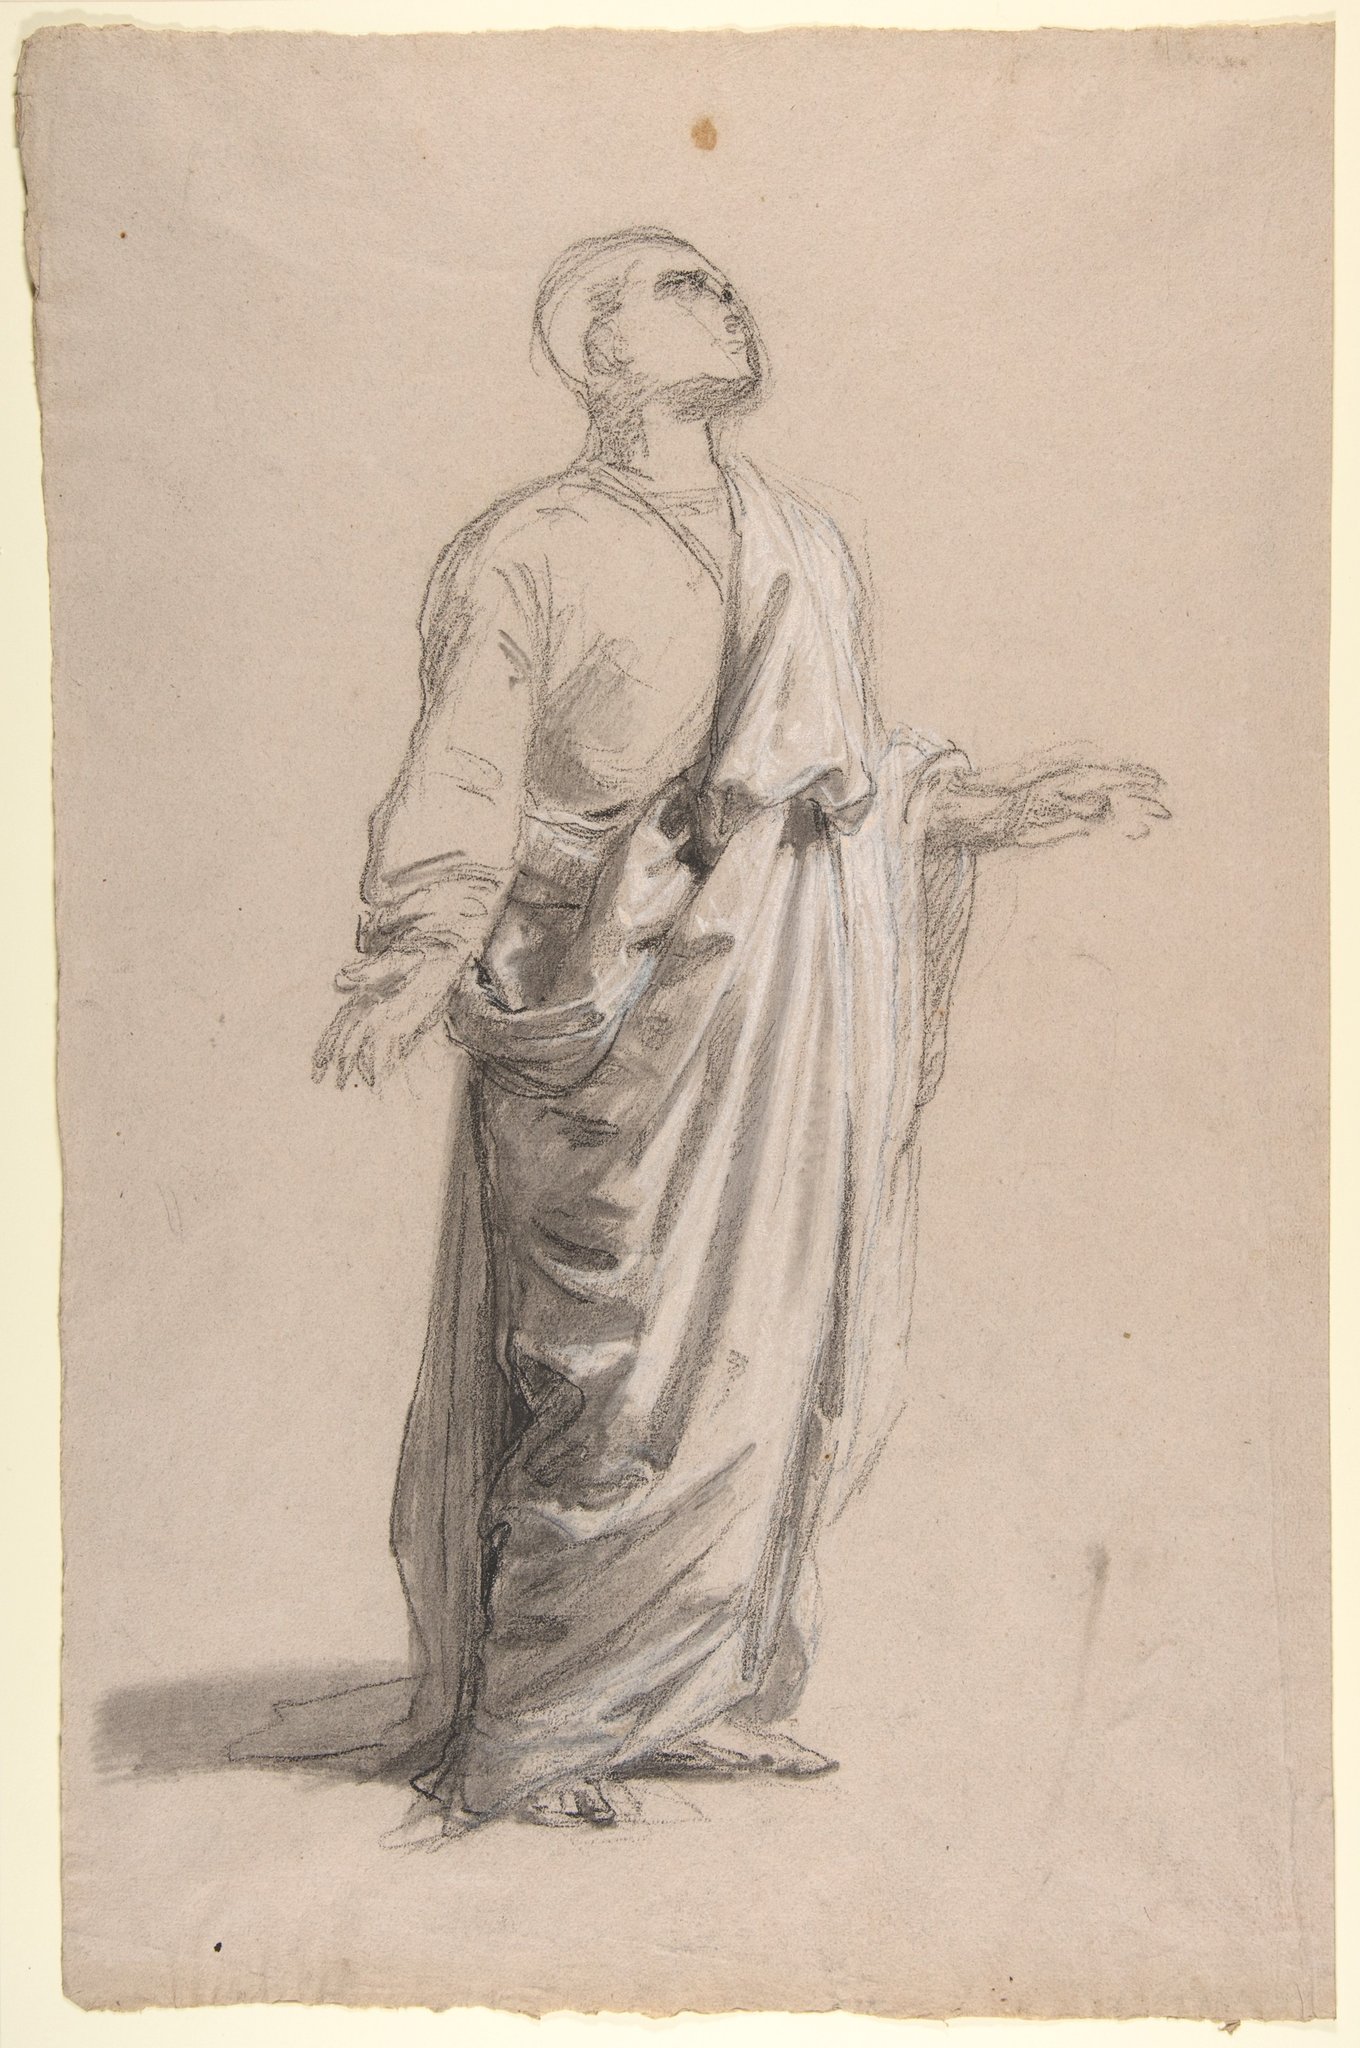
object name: drawing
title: Saint Remi (lower register; study for wall paintings in the Chapel of Saint Remi, Sainte-Clotilde, Paris, 1858)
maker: isidore pils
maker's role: artist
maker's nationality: french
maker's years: 1813-1875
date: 1801-1900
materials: chalk, paper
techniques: stumping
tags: men,saints